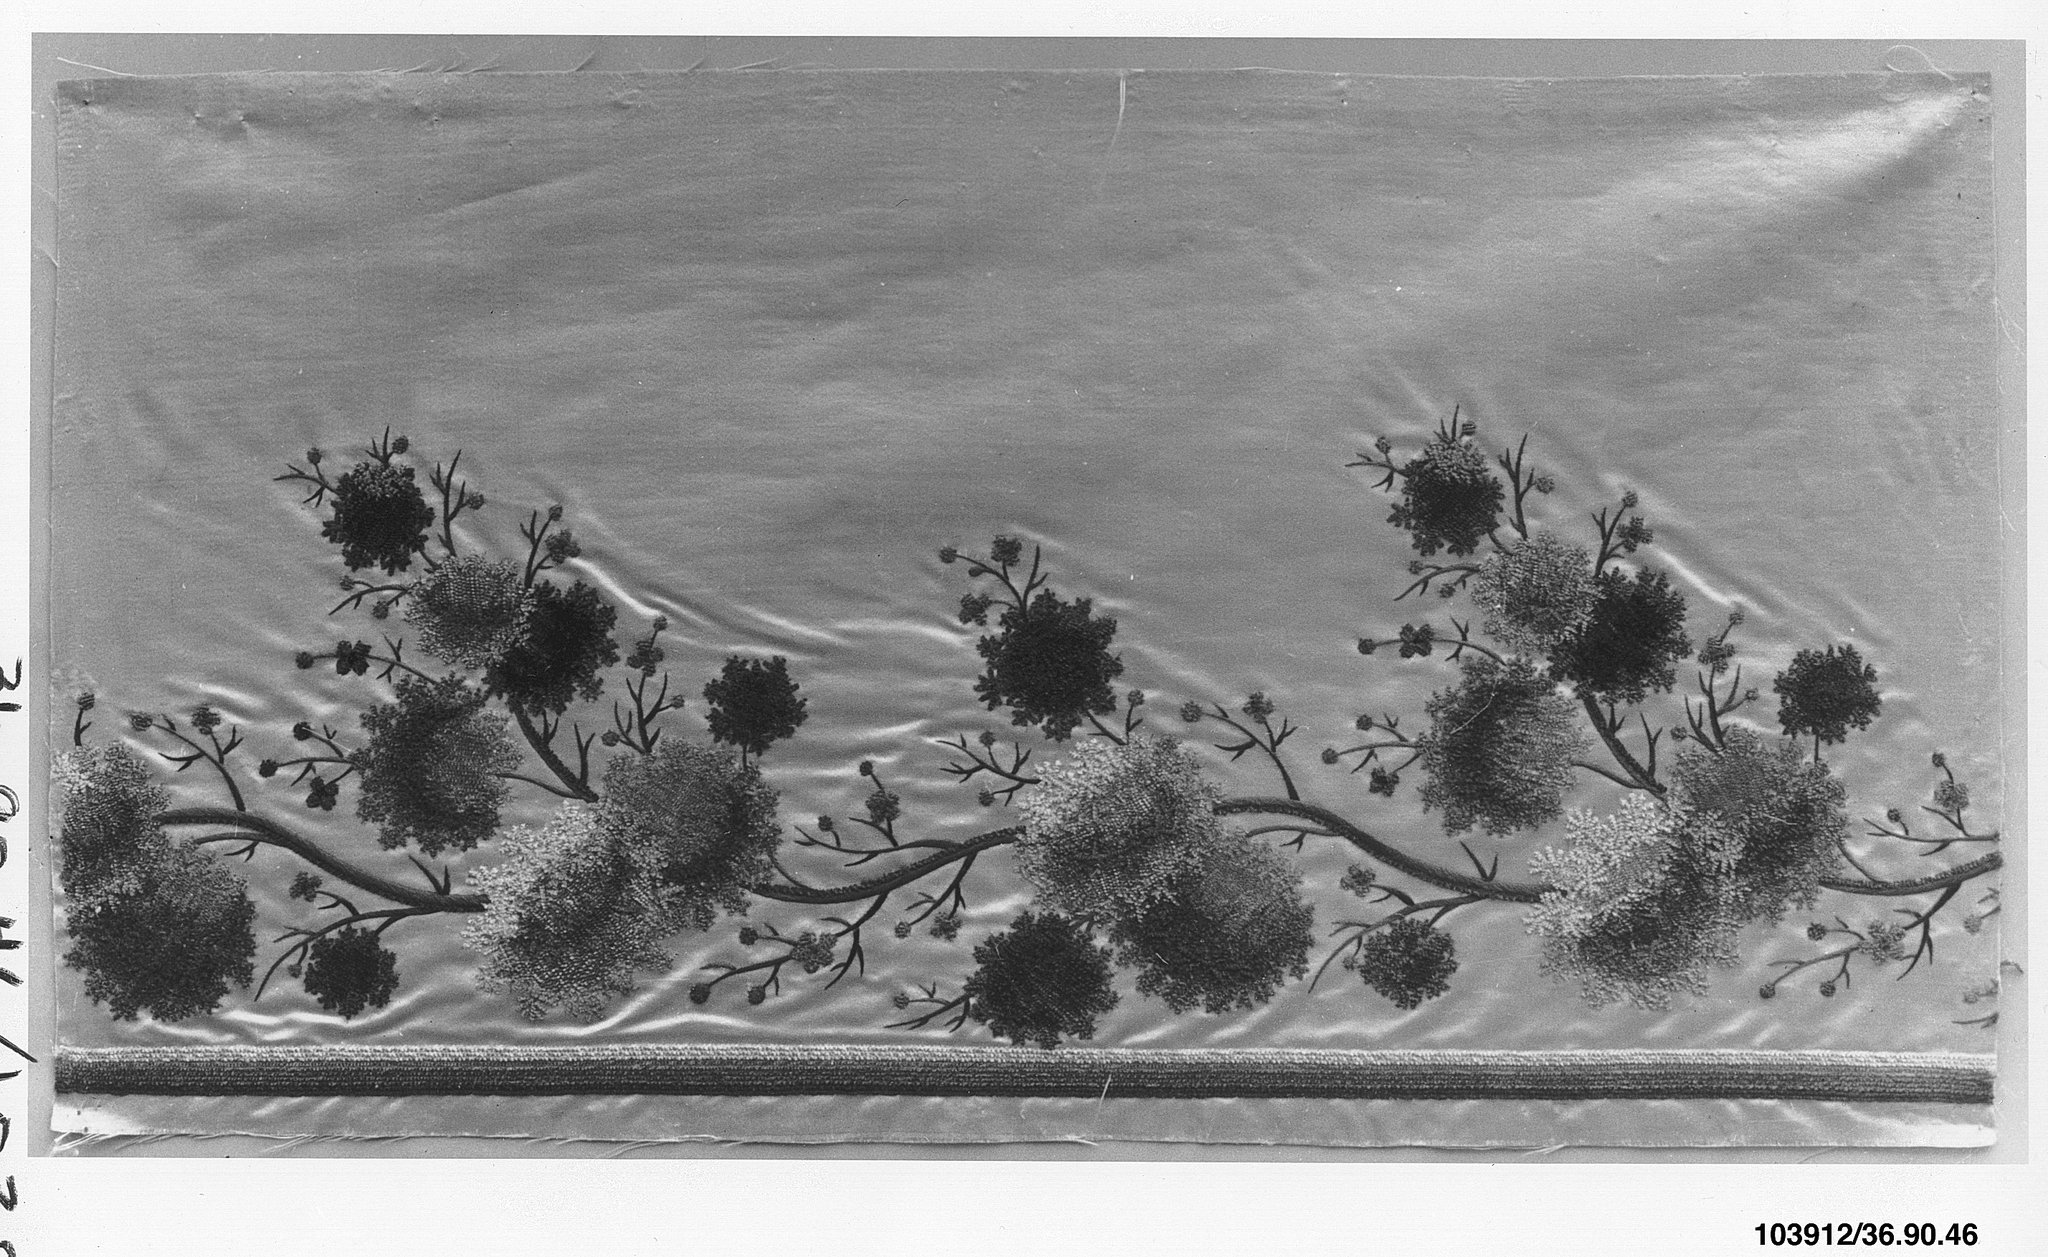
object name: border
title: Dress border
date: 1801-1833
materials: silk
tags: flowers